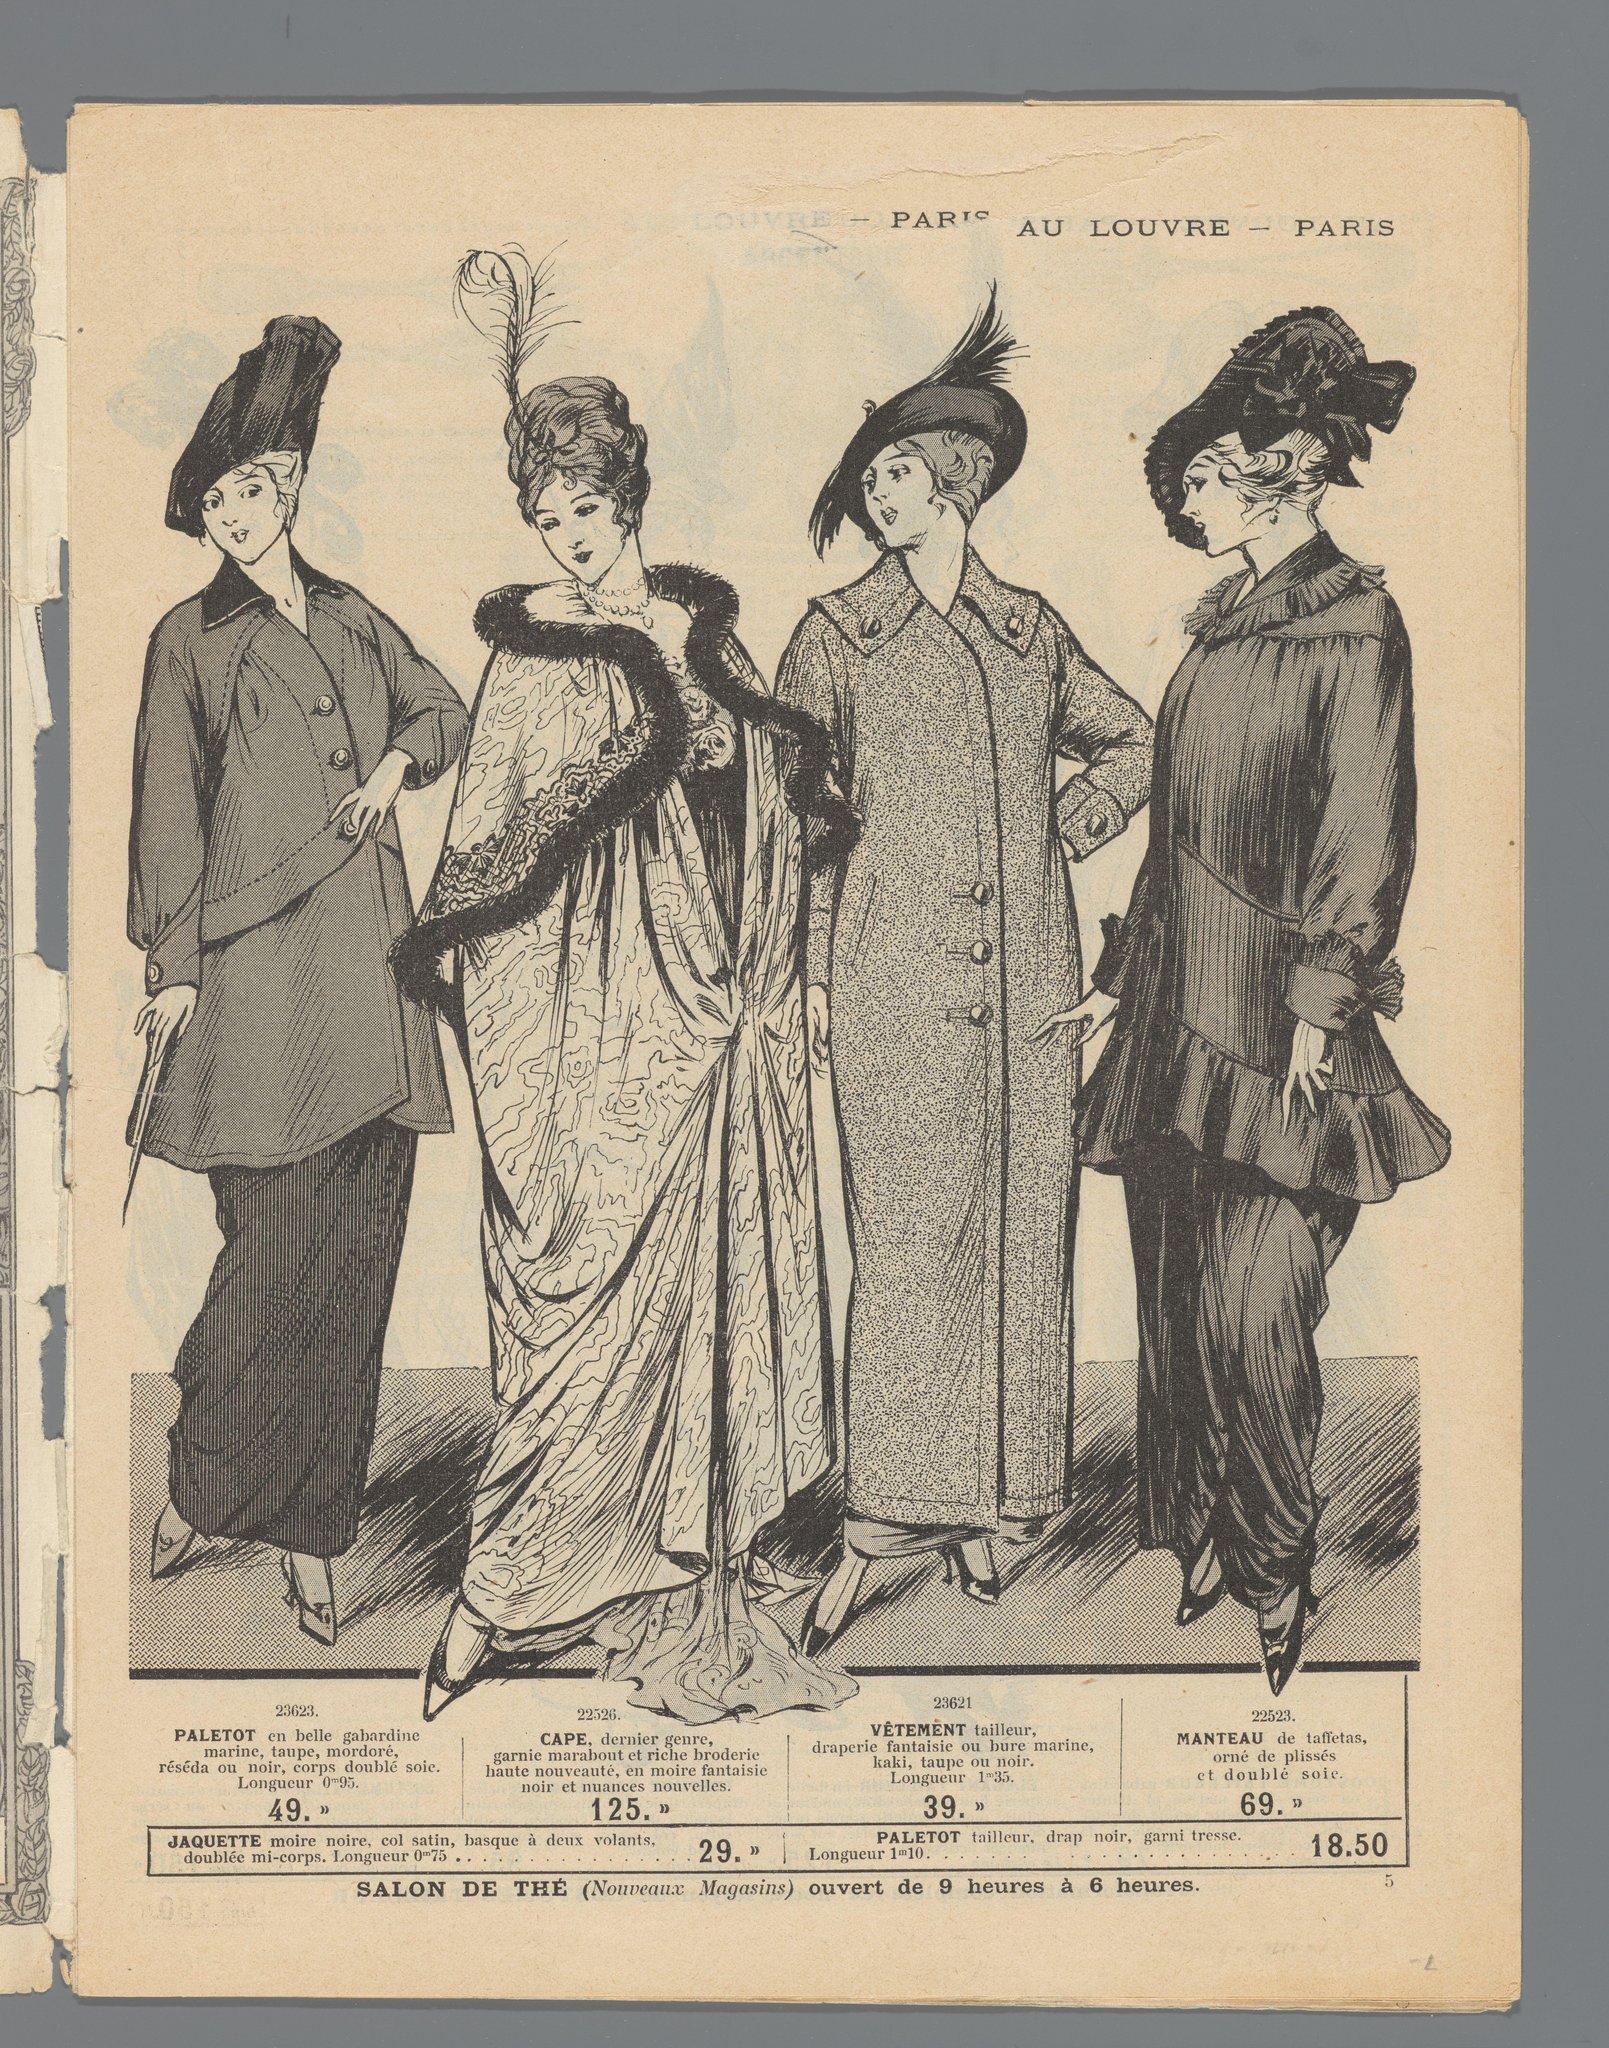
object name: print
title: Au Louvre, Paris: Lundi 2 Mars: Nouveautés d'été: vier modellen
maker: Anonymous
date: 1913-1915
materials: paper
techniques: photography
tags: fashion plates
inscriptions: title: ‘Au Louvre, Paris: Lundi 2 Mars: Nouveautés d'été’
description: Pagina in "Au Louvre - Paris" : vier vrouwen naast elkaar: van links naar rechts: paletot...Cape..., Vêtement tailleur...; Manteau de taffetas.